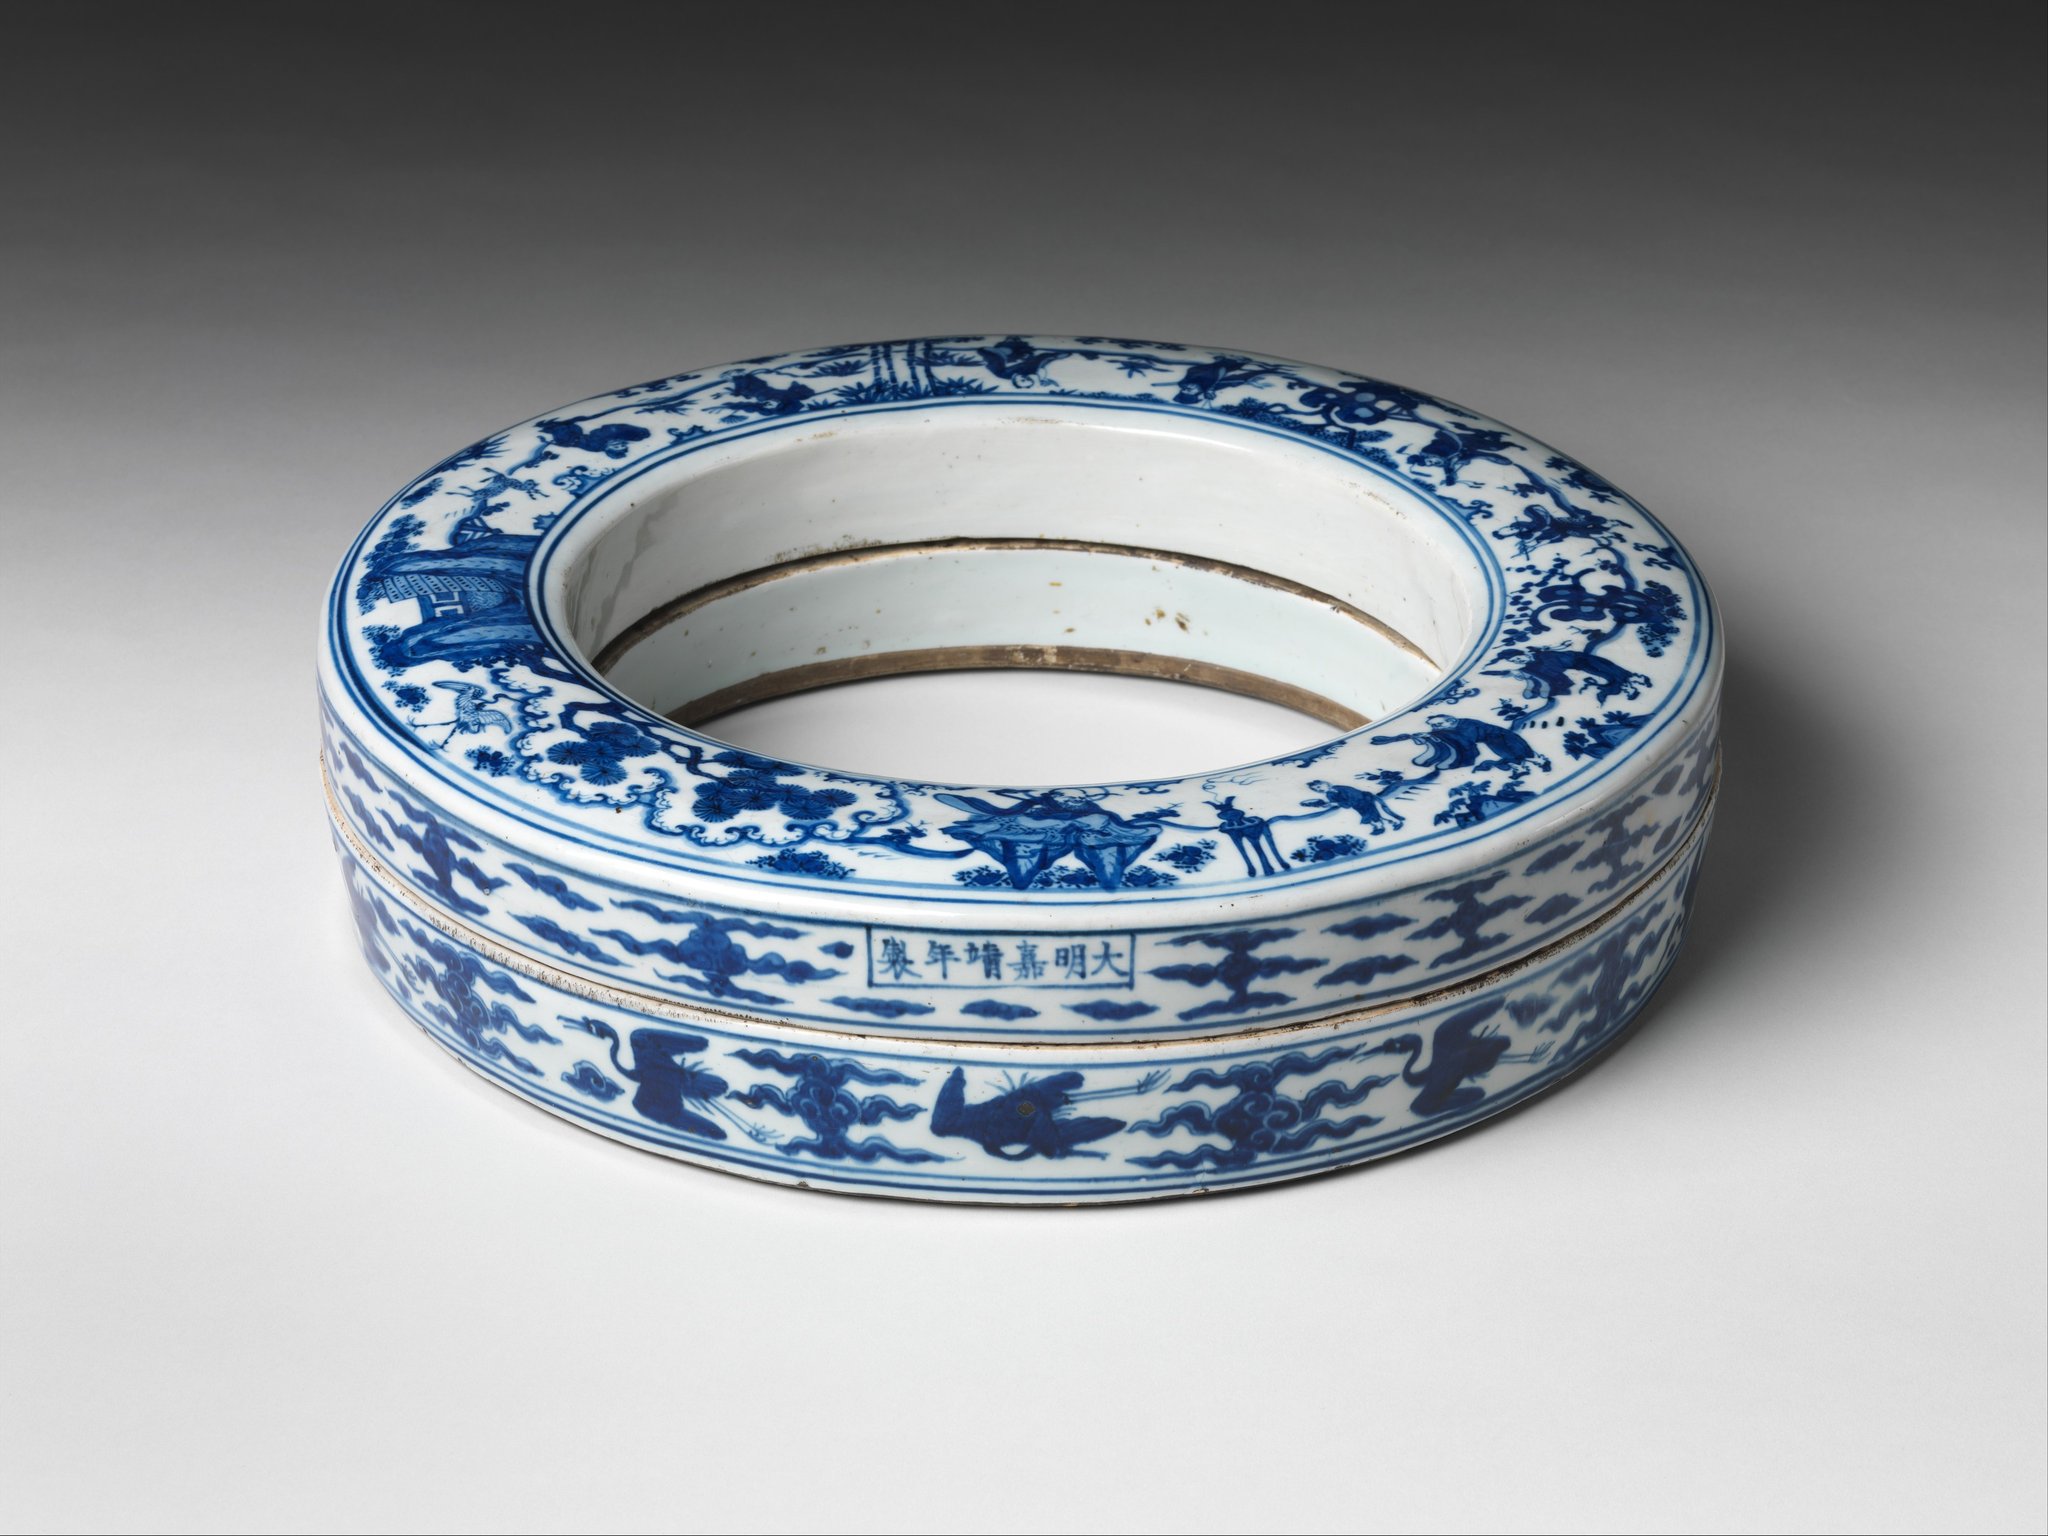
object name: covered box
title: Box with Daoist Immortals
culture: chinese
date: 1534-1566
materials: cobalt, glaze, porcelain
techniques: painting